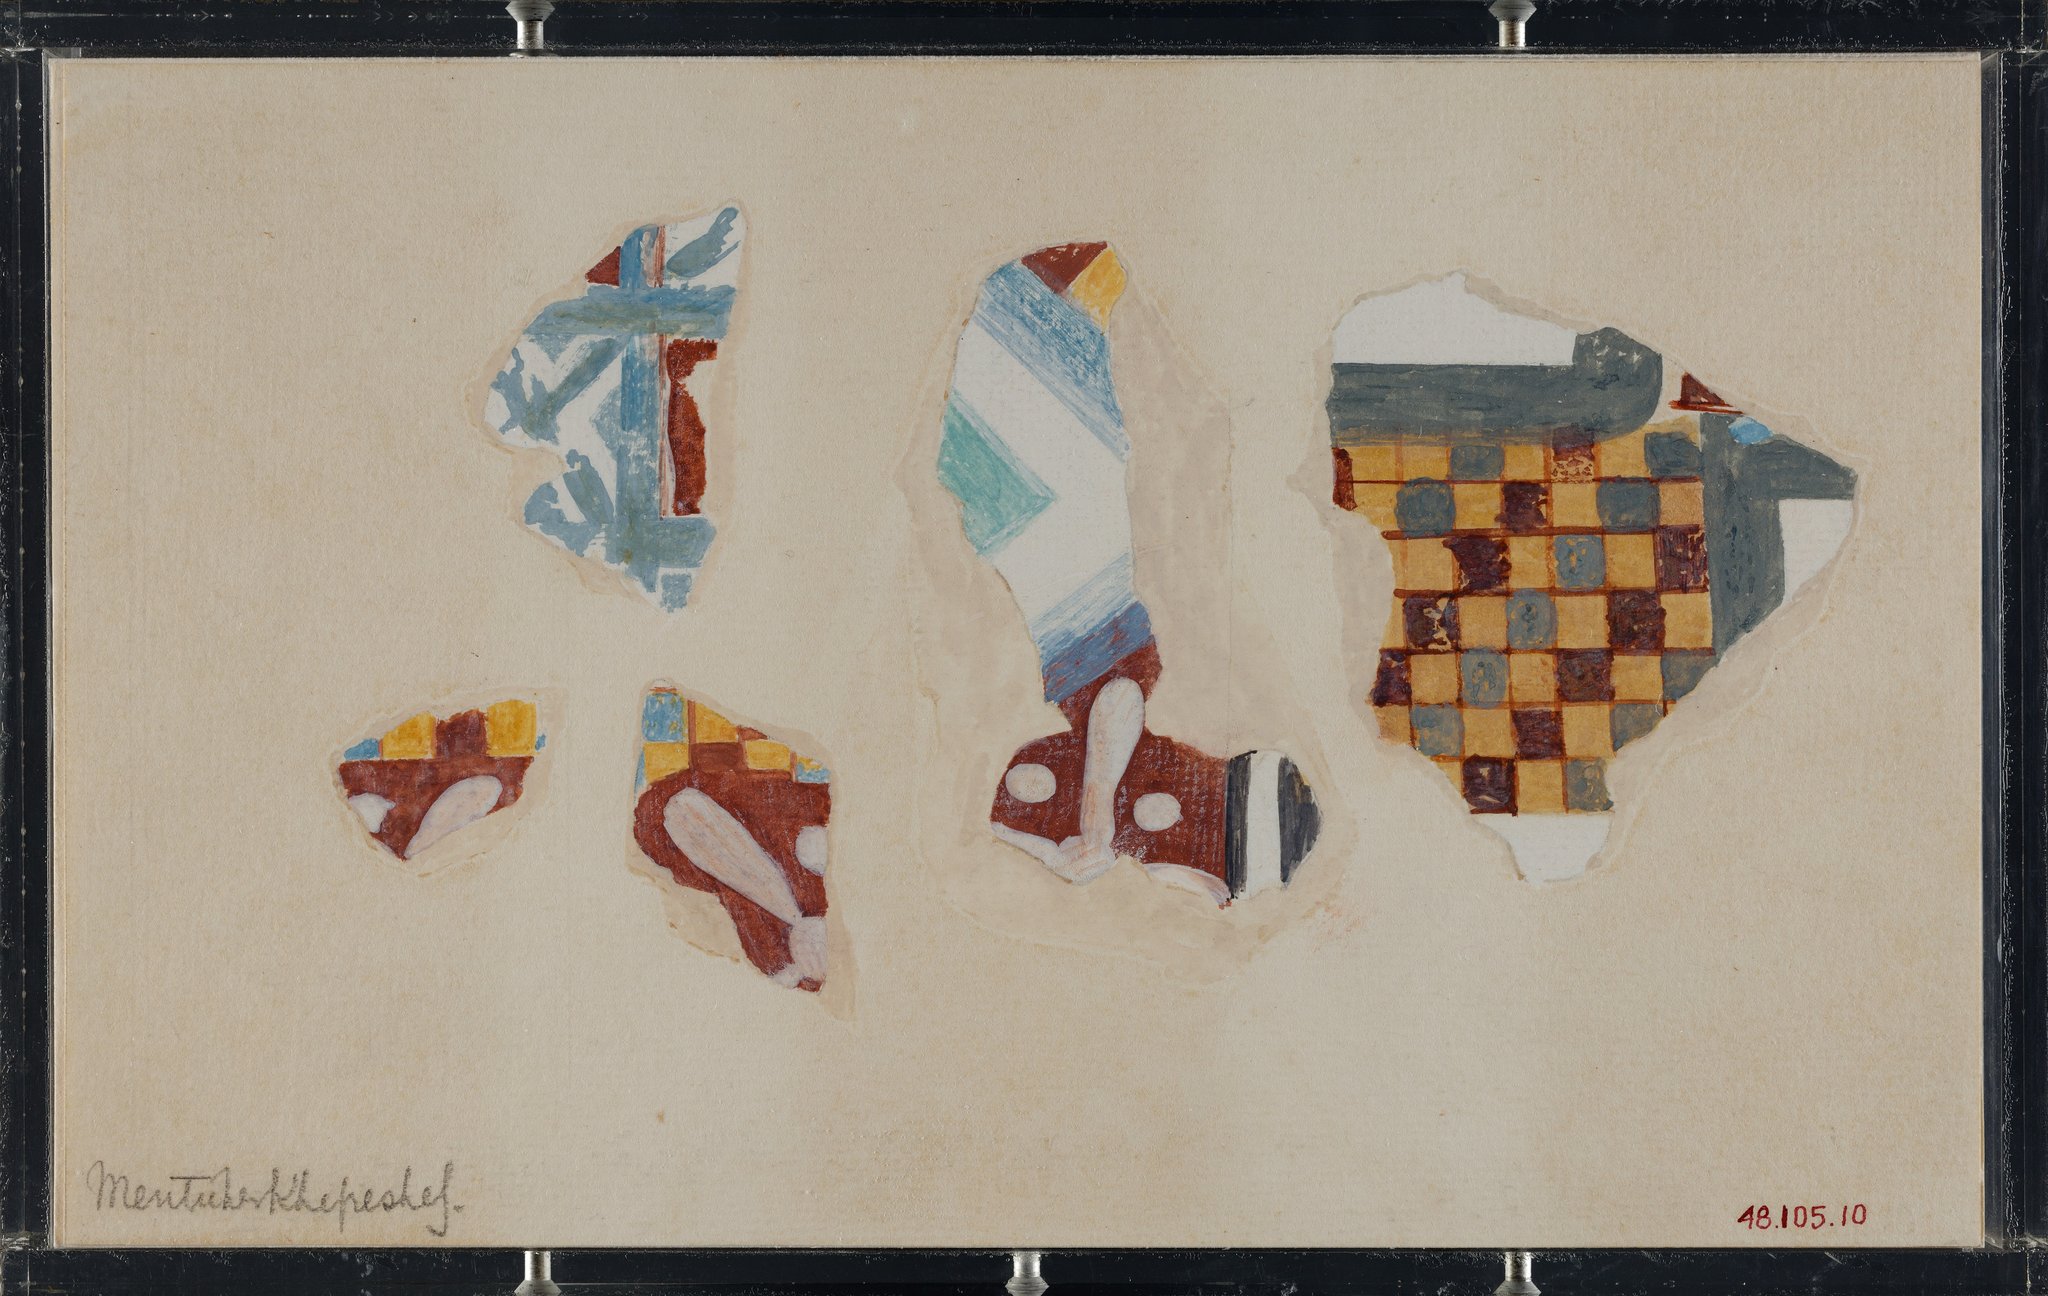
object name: facsimile, mentuherkhepeshef tt 20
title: Fascimile painting from the tomb of Mentuherkhepeshef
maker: unknown copyist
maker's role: artist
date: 1504-1458 BCE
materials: paper, paint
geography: egypt